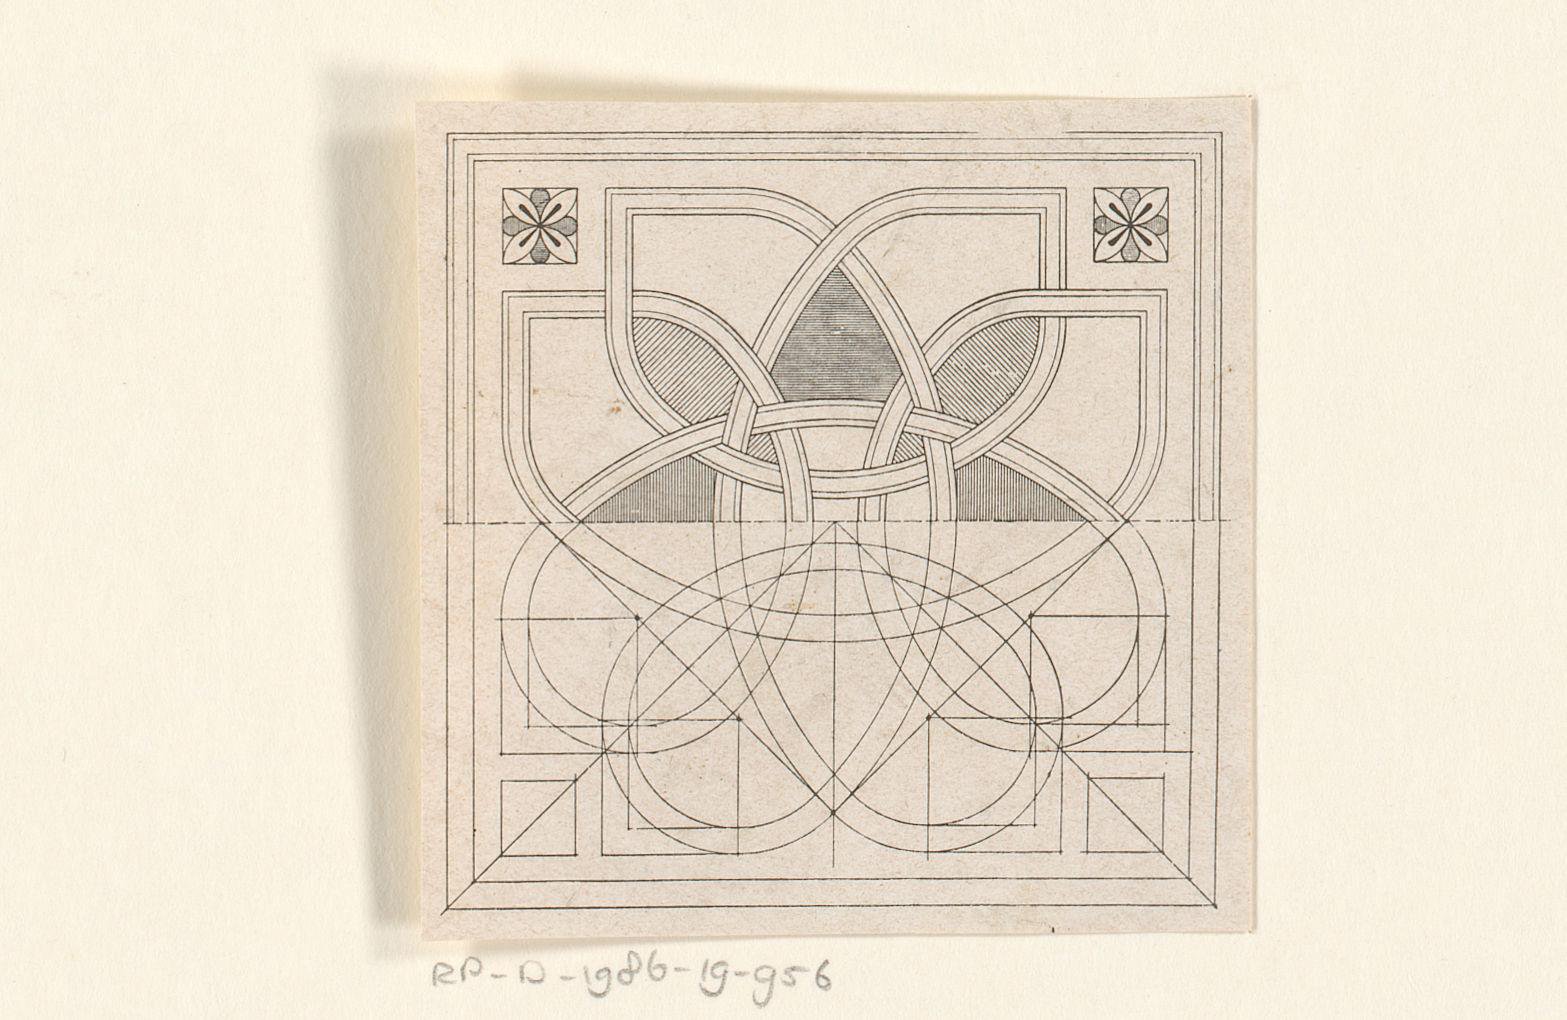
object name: photomechanical print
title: Vlakversiering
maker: Anonymous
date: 1880-1986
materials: paper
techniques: printing block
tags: ornament ~ geometric motifs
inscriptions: collector's mark: ‘R:MVS.’